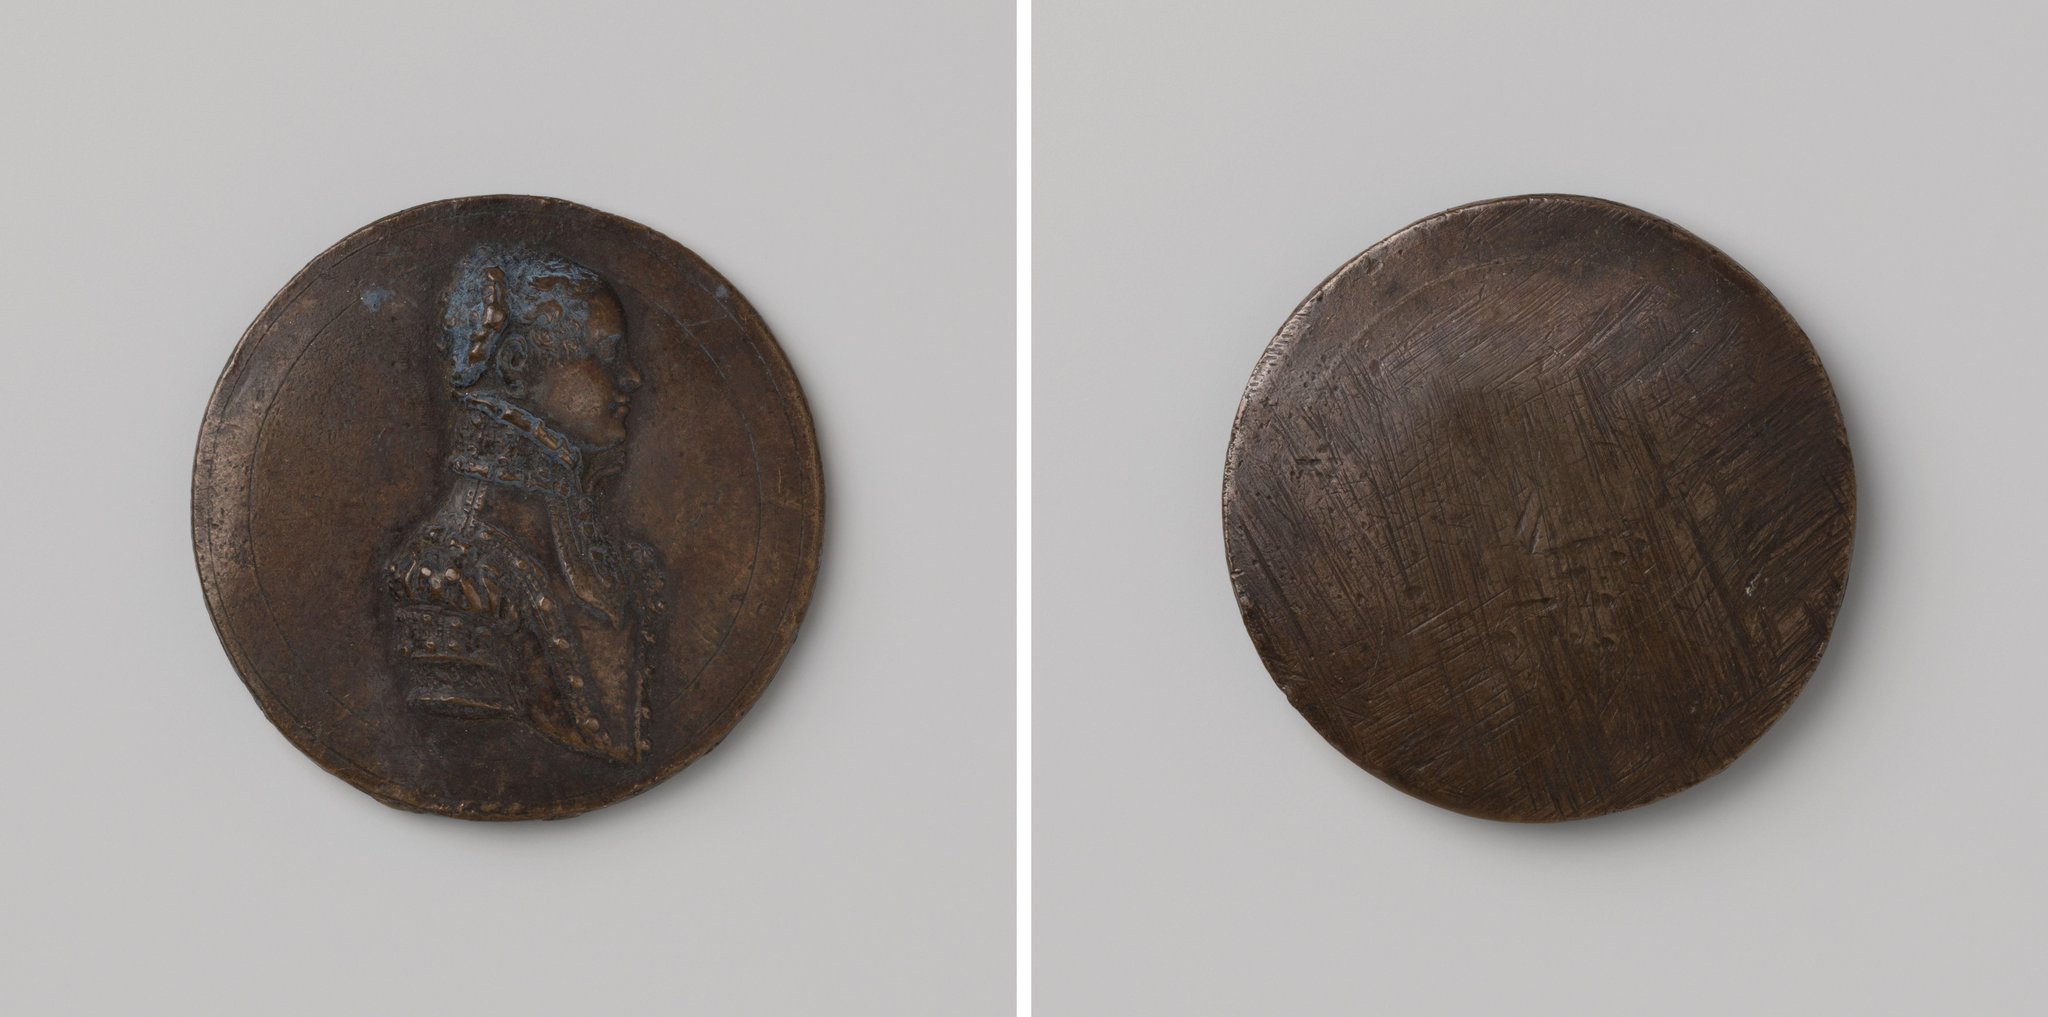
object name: history medal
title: onbekende vrouw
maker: Anonymous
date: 1511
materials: bronze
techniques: casting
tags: historical persons not known by name - bb - woman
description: Eenzijdige bronzen penning. Voorzijde: borststuk vrouw naar rechts; vlak begrensd door twee met passer gegraveerde cirkels t.b.v. omschrift. Keerzijde: blanco